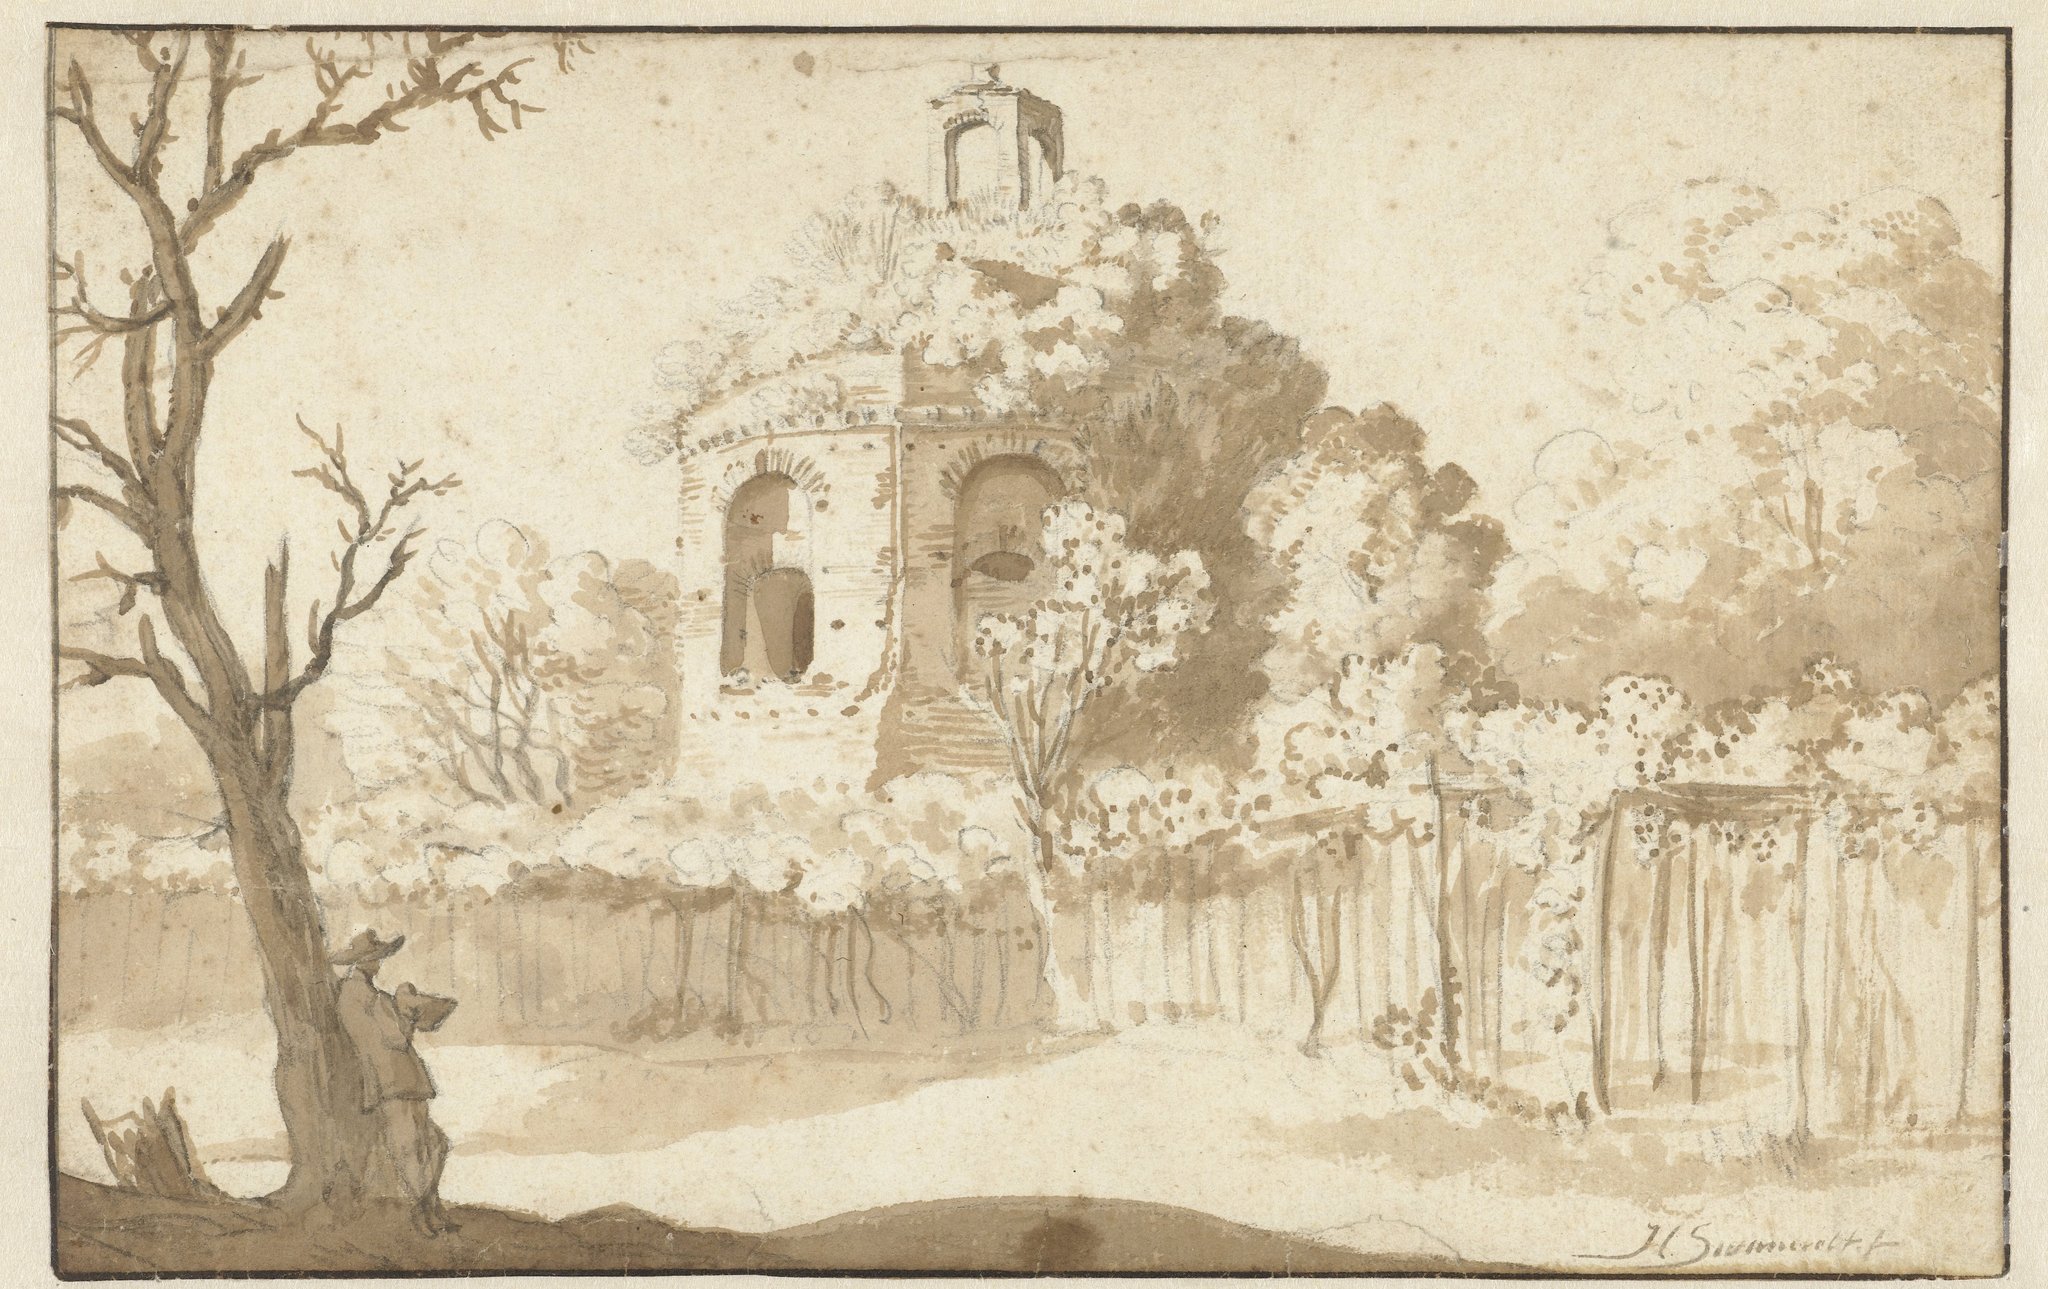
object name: drawing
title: Landschap met ruïne en tekenaar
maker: herman van swanevelt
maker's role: draughtsman, painter, print maker, publisher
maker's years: 1603-1655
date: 1629-1641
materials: chalk, paper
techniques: brush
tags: ruin of a building ~ architecture, draughtsman studying classical remains - cc - out of doors, italy